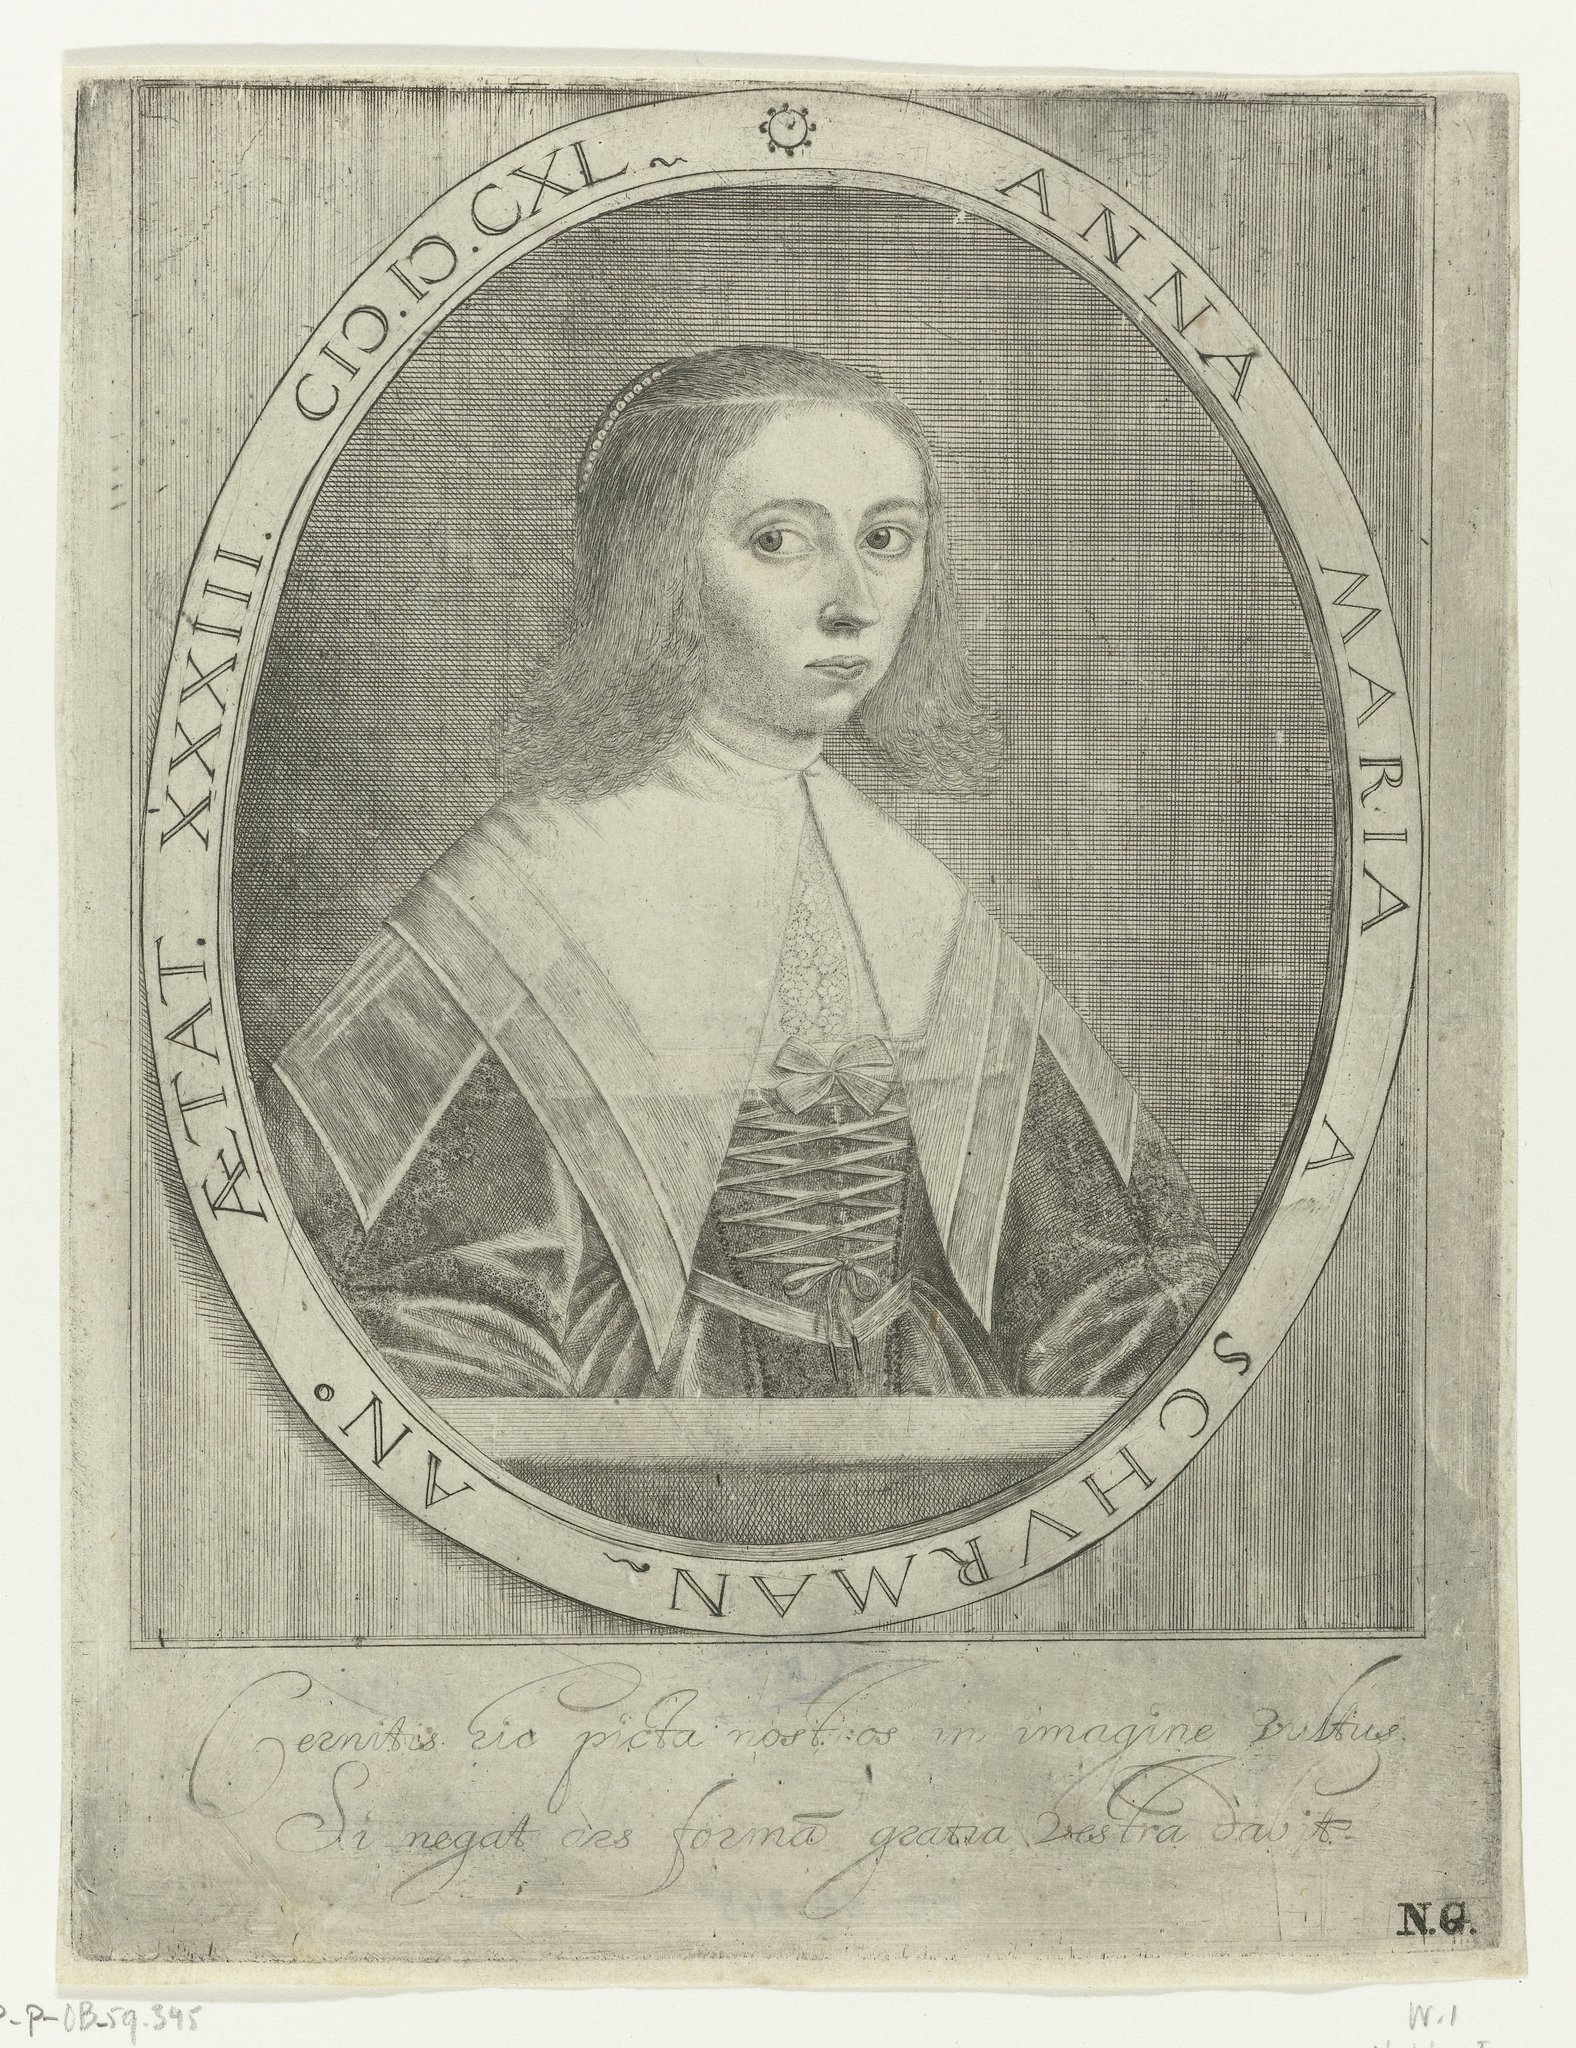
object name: print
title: Zelfportret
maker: anna maria van schurman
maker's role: draughtsman, print maker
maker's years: 1607-1678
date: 1640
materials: paper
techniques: engraving, etching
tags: cologne, print maker, draughtsman, anna maria van schurman, portrait, self-portrait of artist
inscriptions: collector's mark: Lugt 2228, collector's mark: Lugt 1967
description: Zelfportret van Anna Maria van Schurman, geleerde, dichteres en kunstenares.